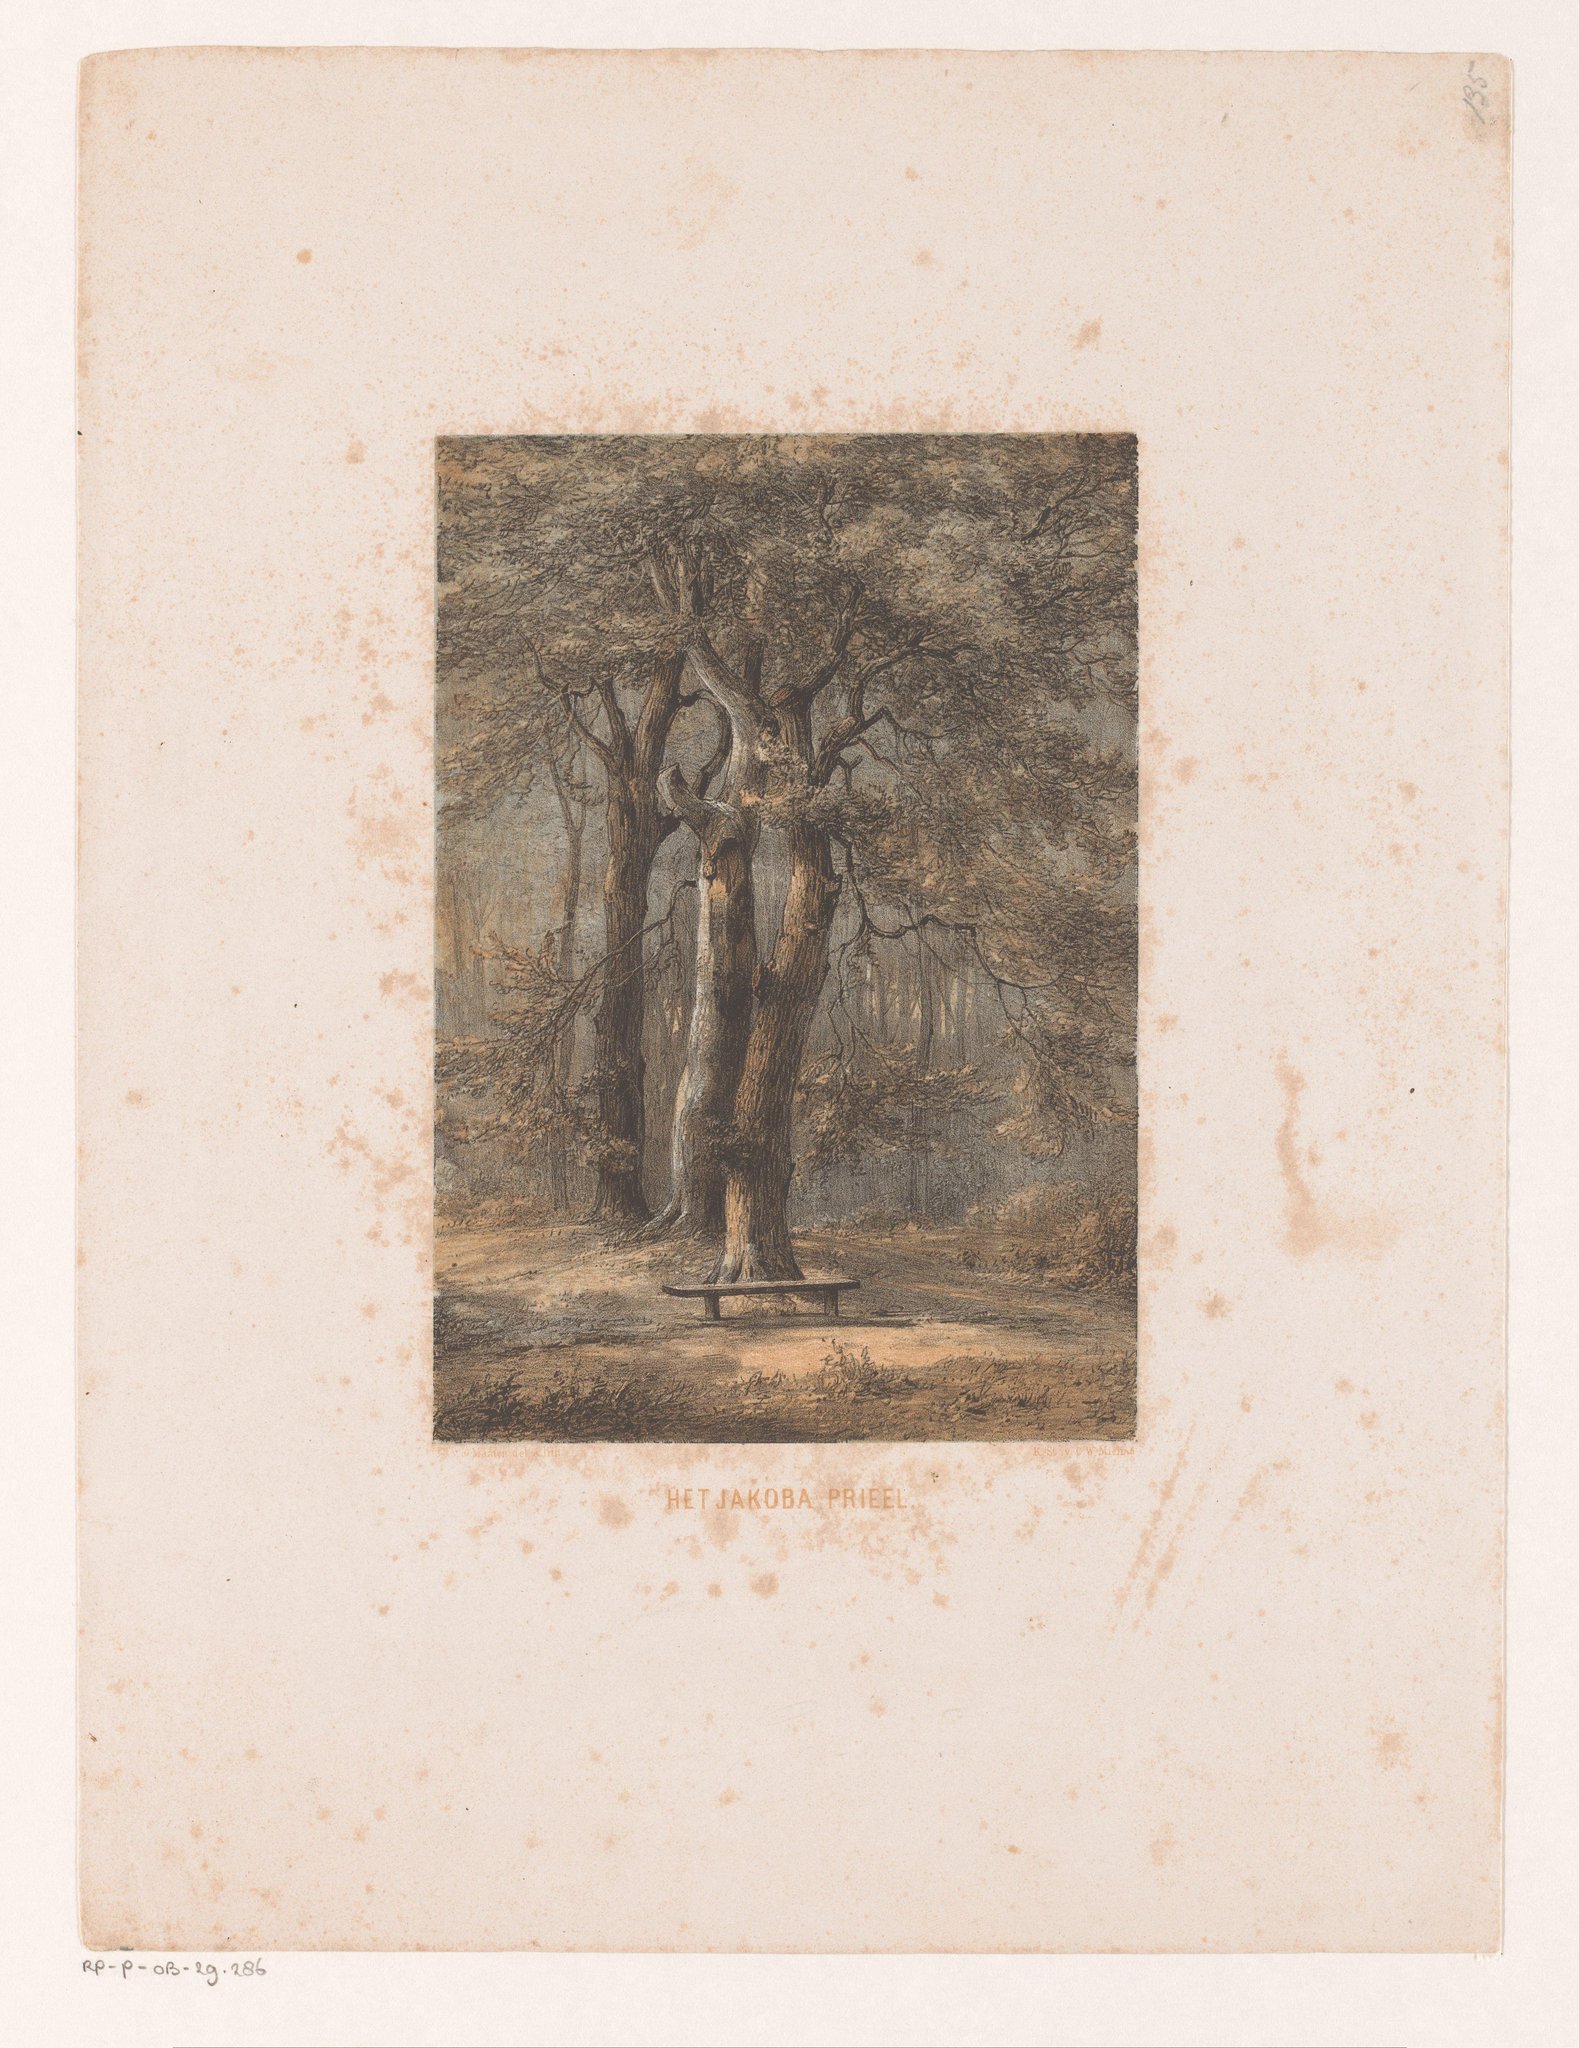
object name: print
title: Het Jakoba prieel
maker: jacob jan van der maaten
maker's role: draughtsman, print maker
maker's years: 1820-1879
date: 1859-1864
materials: paper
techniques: tone lithography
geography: the hague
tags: jacoba of bavaria (countess of hainaut), bench, groups of trees, trees: beech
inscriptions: collector's mark: Lugt 2228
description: Voor de groep bomen staat een houten bank.